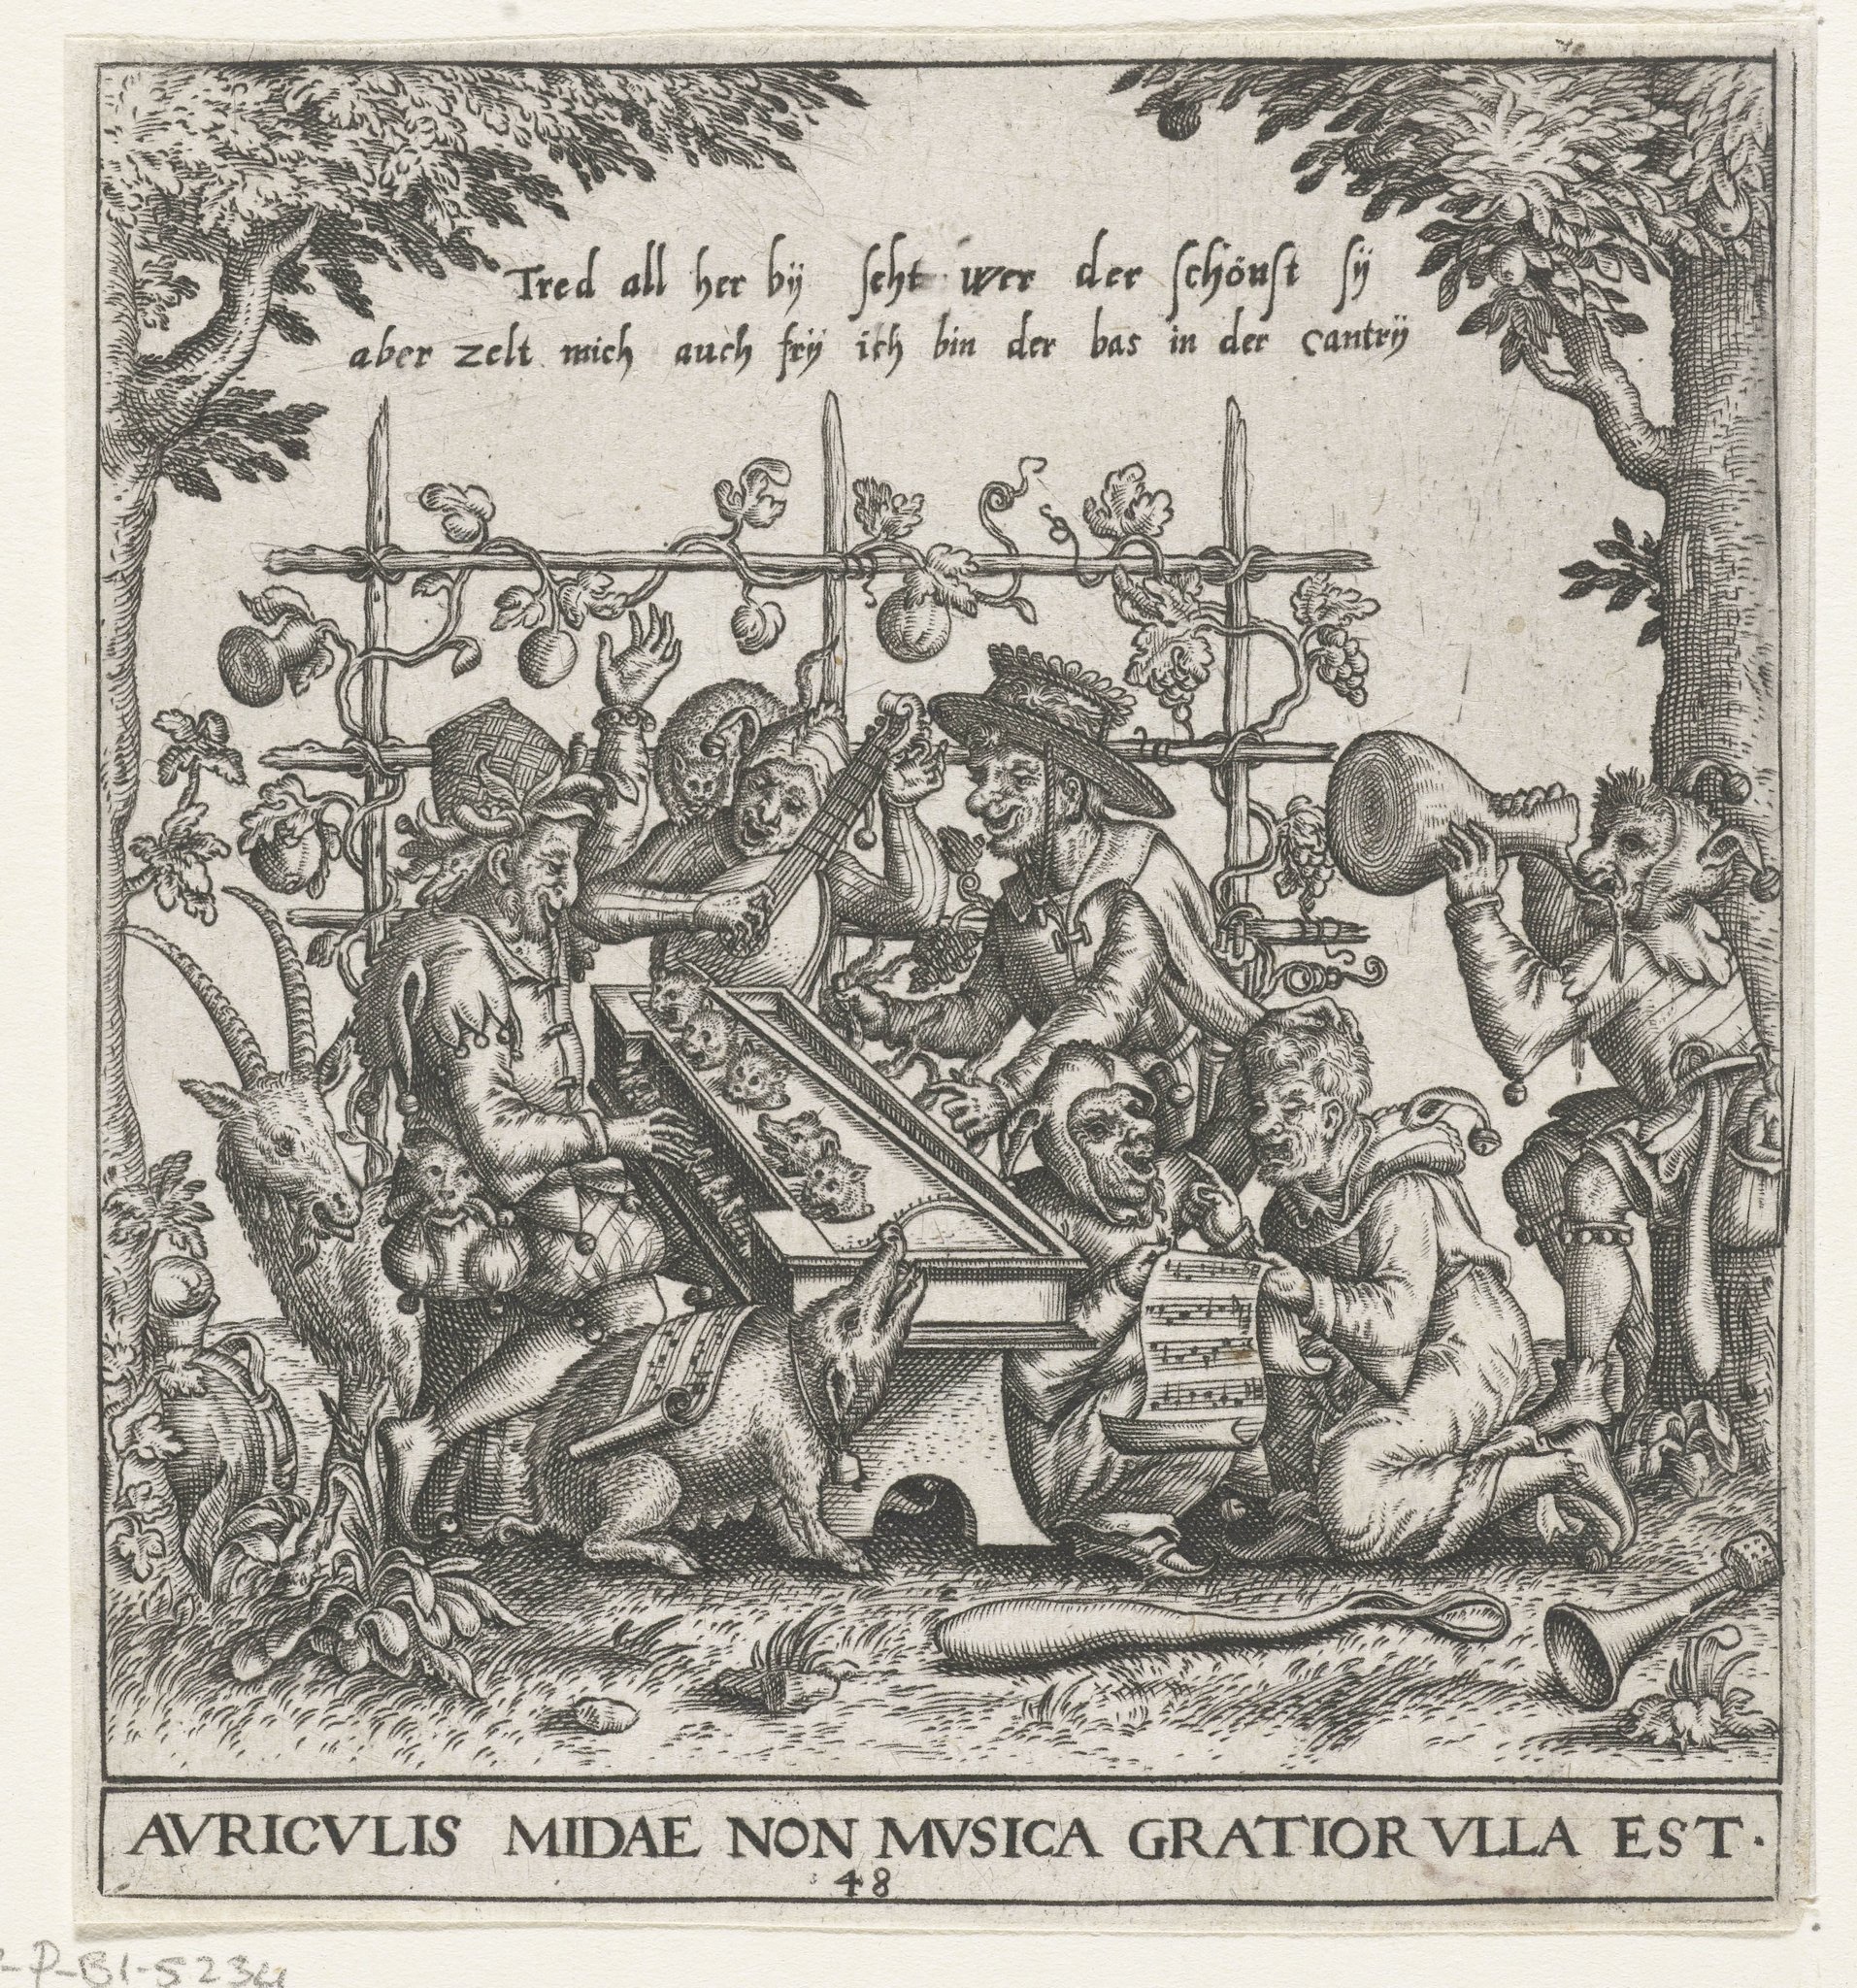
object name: book illustration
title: Emblemata Saecularia, 1596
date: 1596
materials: paper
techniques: engraving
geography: frankfurt am main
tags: existence and modes of existence (+ emblematical representation of concept), pot-and-pan orchestra, rough music, fool, simpleton, numskull, improvised musical instruments (kitchen-utensils, etc.)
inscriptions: number: ‘48’, collector's mark: Lugt 240, inscription: ‘Tred all her by seht wer der schönst sy, aber zelt mich auch frij, ich bin der bas in der cantrij,’, inscription: ‘AURICULIS MIDAE NON MUSICA GRATIOR ULLA ESTA’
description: In het midden staat een clavichord waarin katten en honden opgesloten zitten. Het instrument wordt "bespeeld" door op hun poten te tokkelen en aan hun staarten te trekken. De nar naast het fantasieinstrument is zijn luit nog aan het stemmen. De zanger houdt zijn muziekblad ondersteboven, zodat de lezers kunnen zien dat er een vierstemmig lied wordt gezongen. In tegenstelling tot het musicerend gezelschap dat de Bry eerder in zijn serie toonde (nr.7) gaat het hier niet om de verheven harmonie, maar om de wanklank in de muziek. Met deze vorm van "toonkunst" worden waarschijnlijk de disharmonische, "duivelse" klanken bedoeld die werden geproduceerd door rondtrekkende muzikanten, die als drinkende en potverterende lieden slecht stonden aangeschreven.